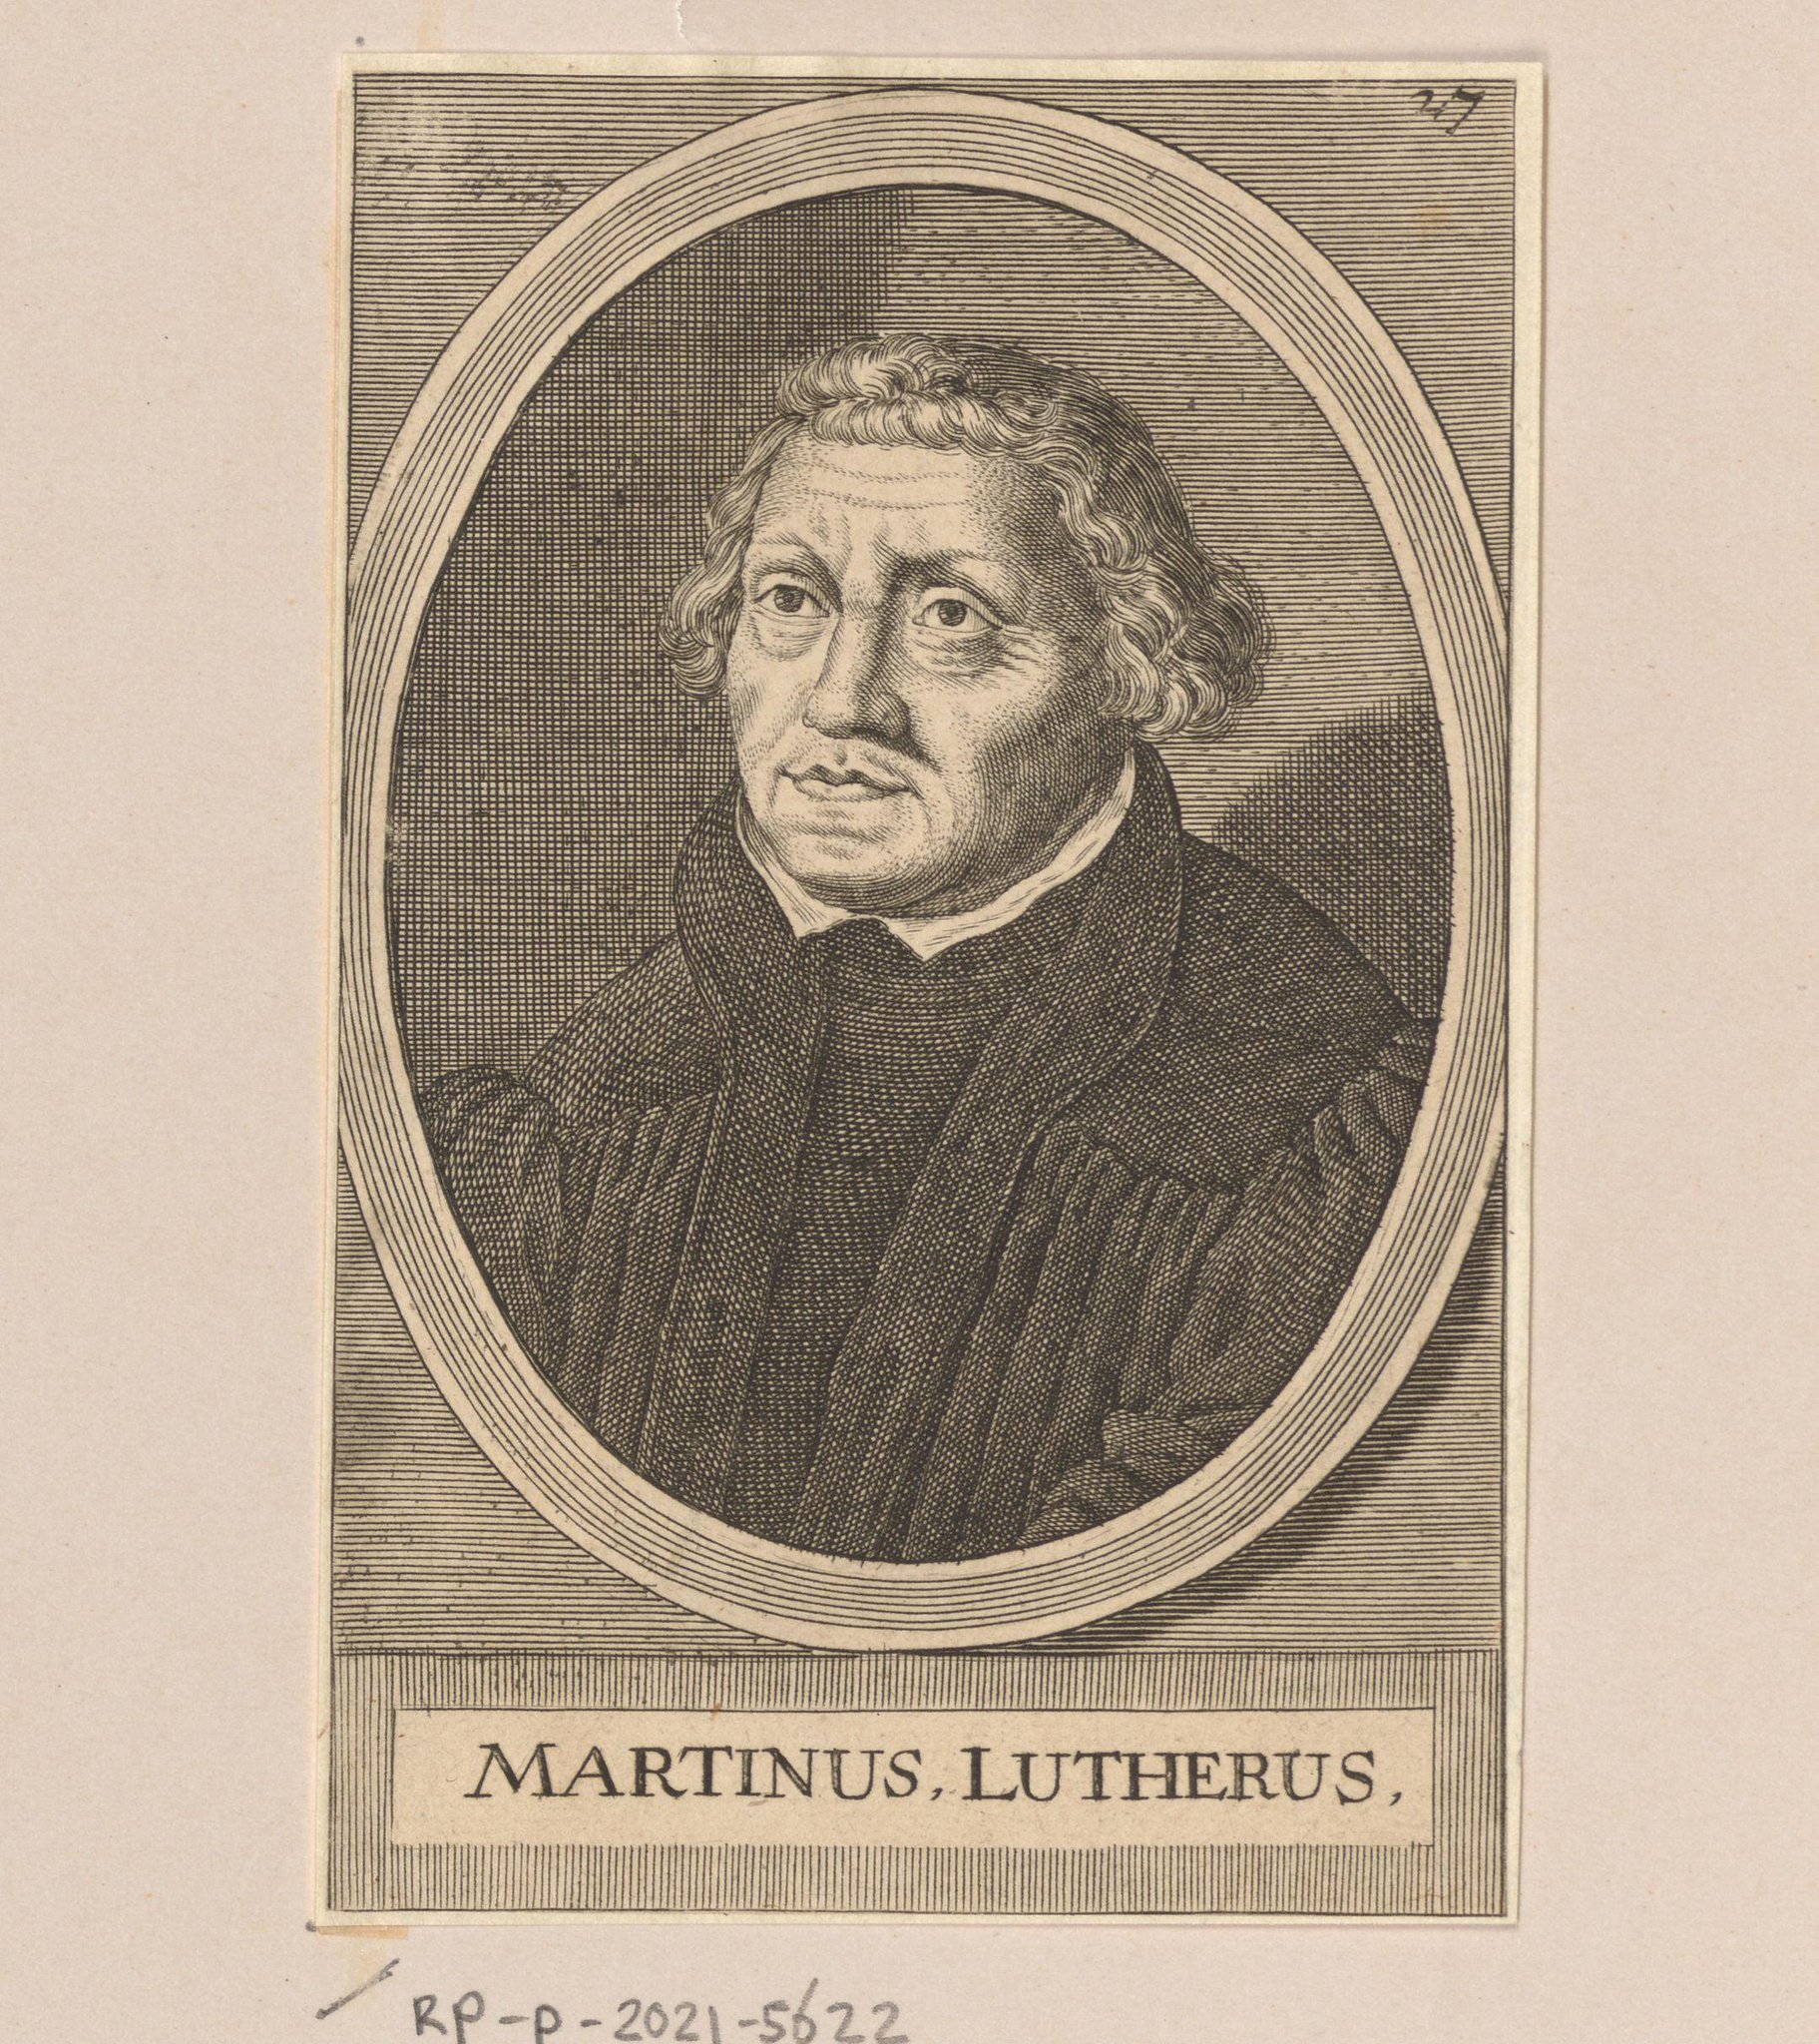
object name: print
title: Portret van Martin Luther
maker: Anonymous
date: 1650-1720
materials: paper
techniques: engraving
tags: priest, martin luther, theologian, ornament ~ medallion, historical persons